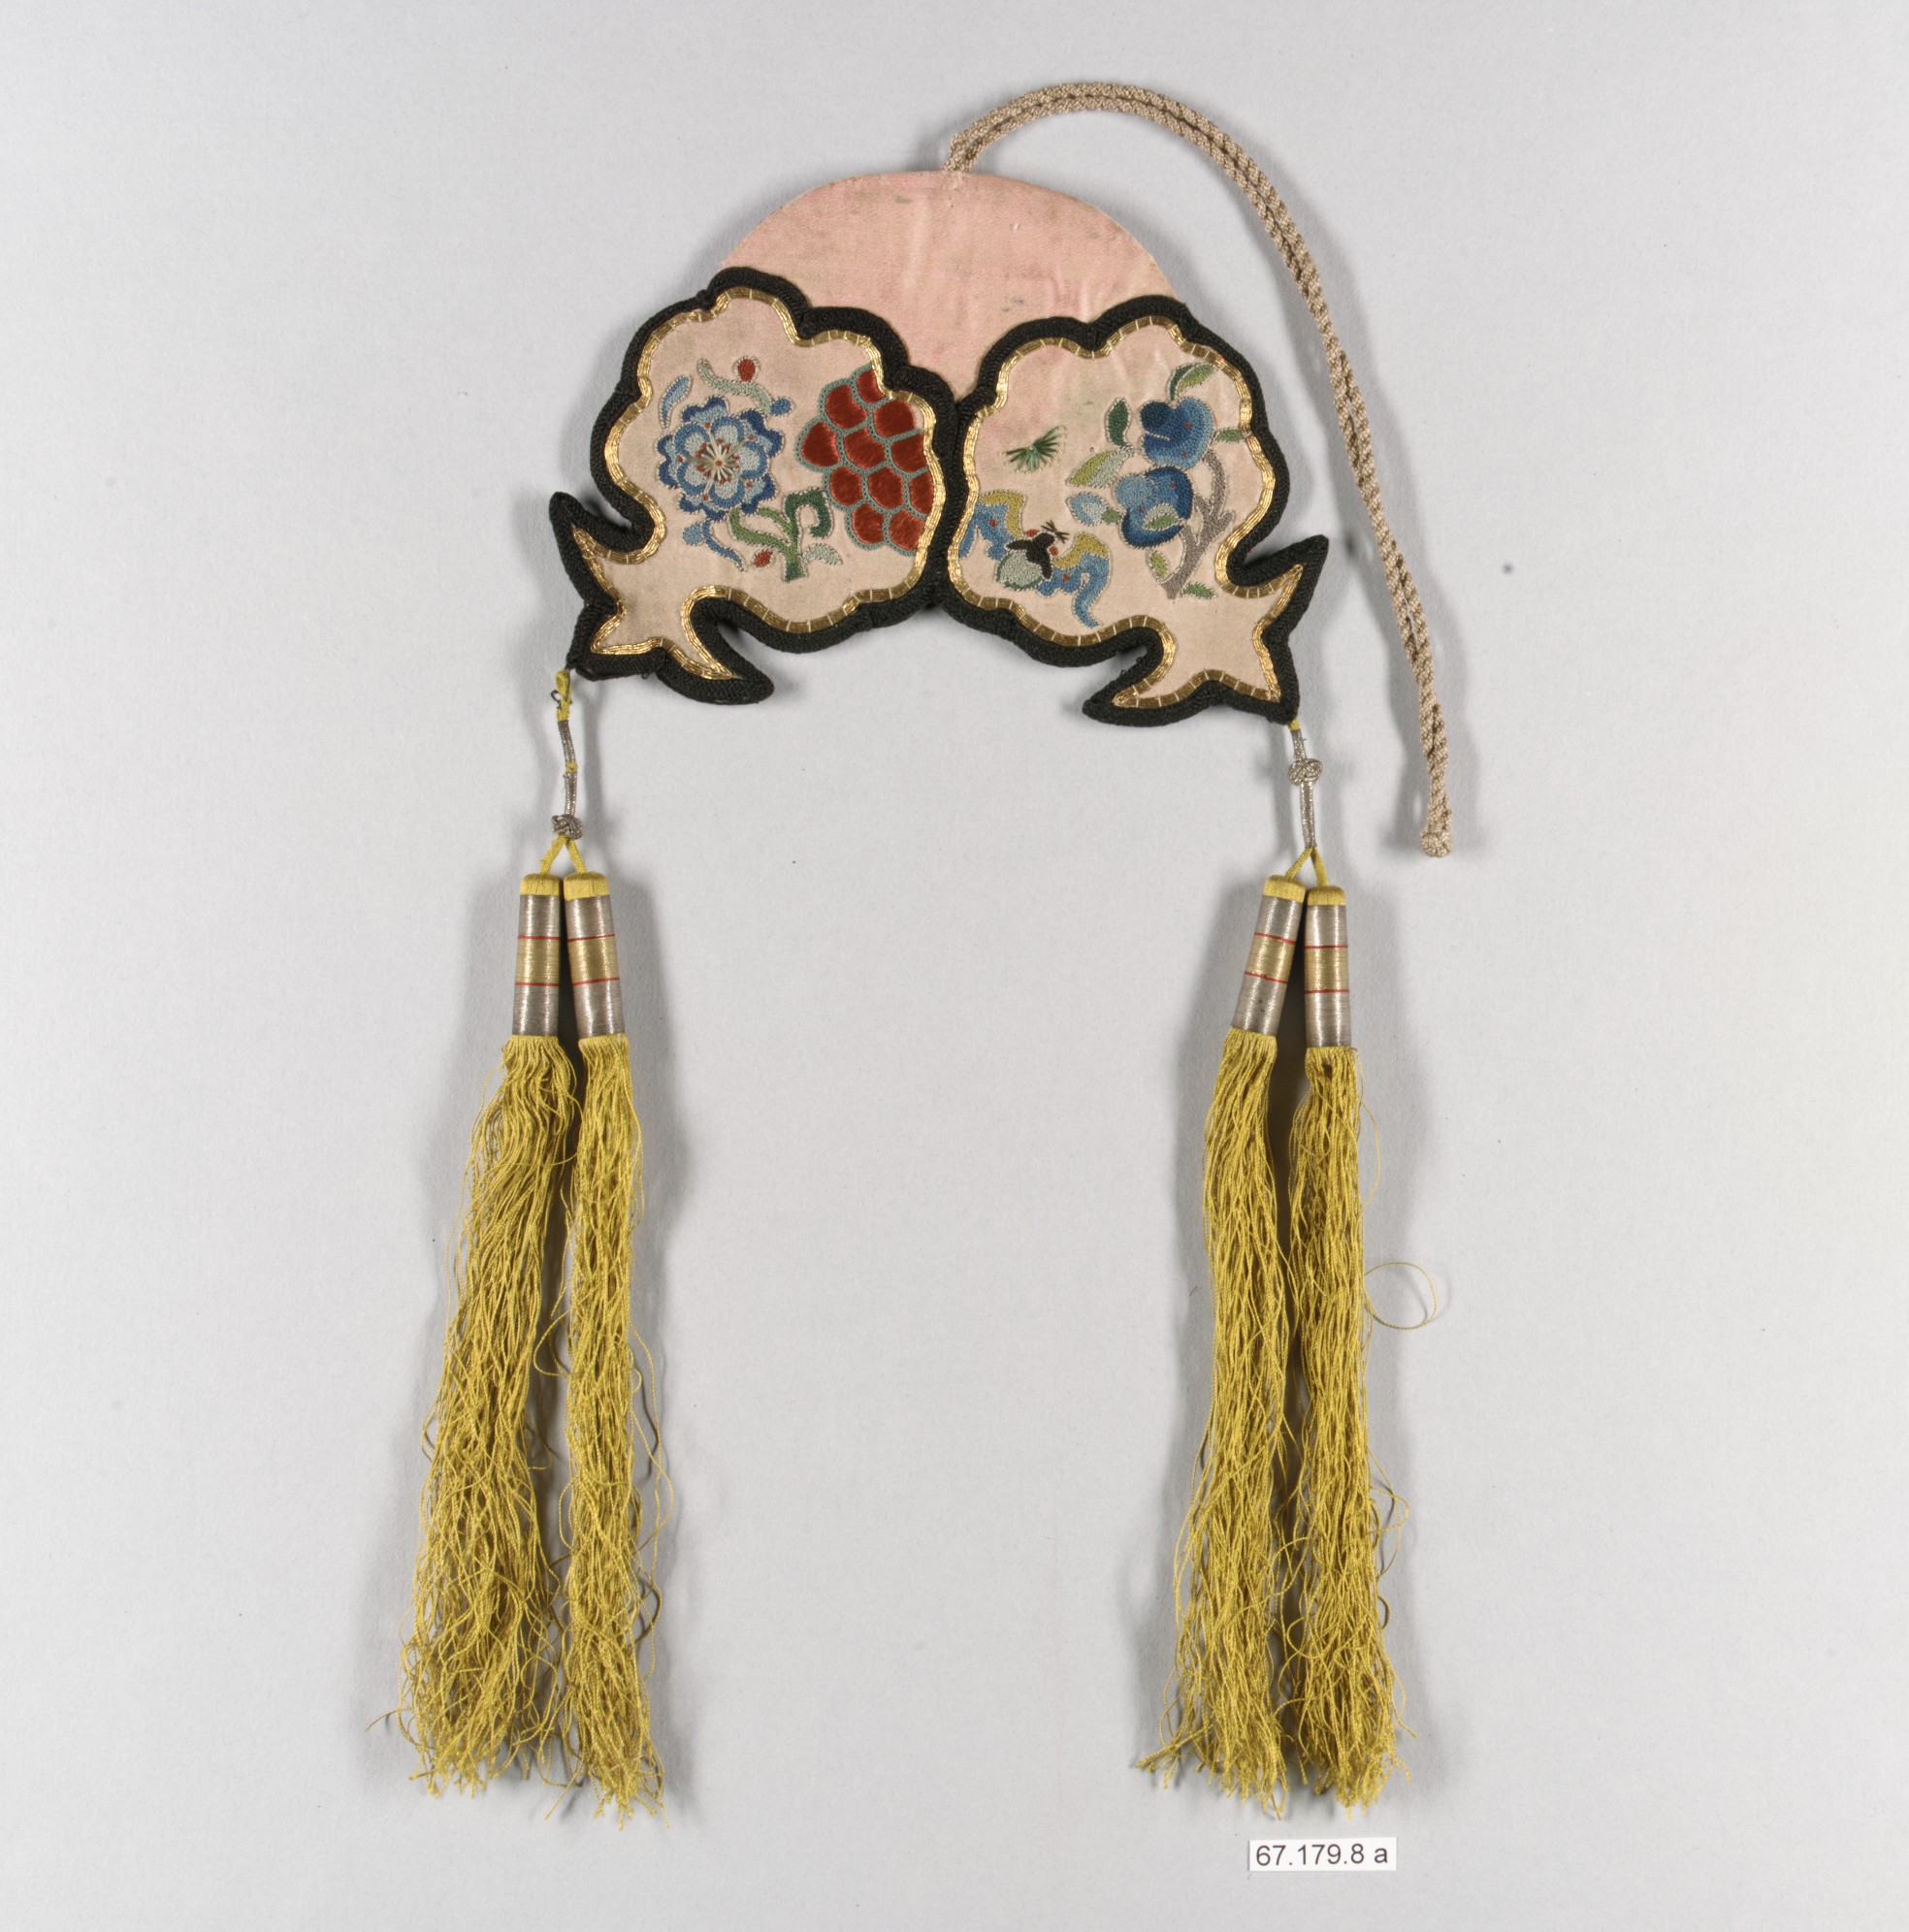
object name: case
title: Case with Cover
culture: chinese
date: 1801-1900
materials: metal thread, silk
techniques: embroidery, weave